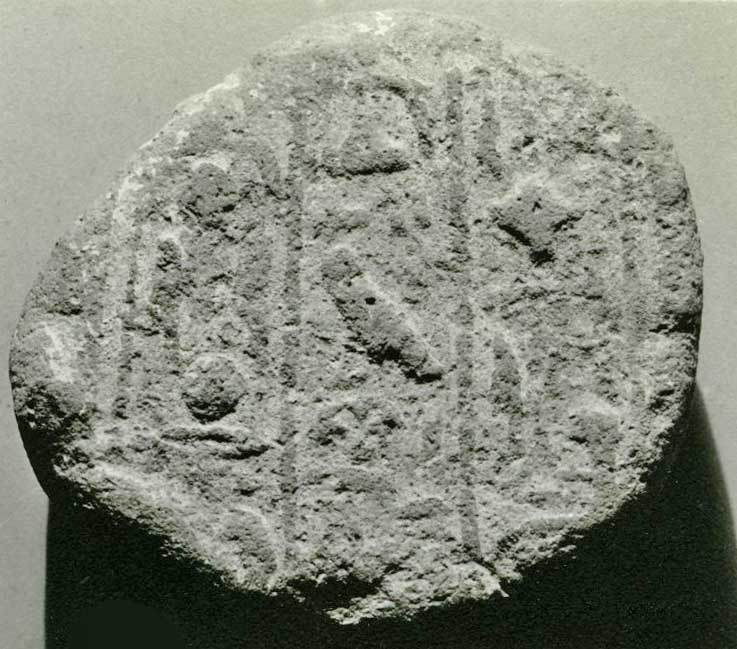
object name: cone, heriry, rectangular impression, overseer, double granary, southern city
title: Funerary Cone of the Scribe Heriry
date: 1550-1295 BCE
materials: pottery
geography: egypt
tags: hieroglyphs